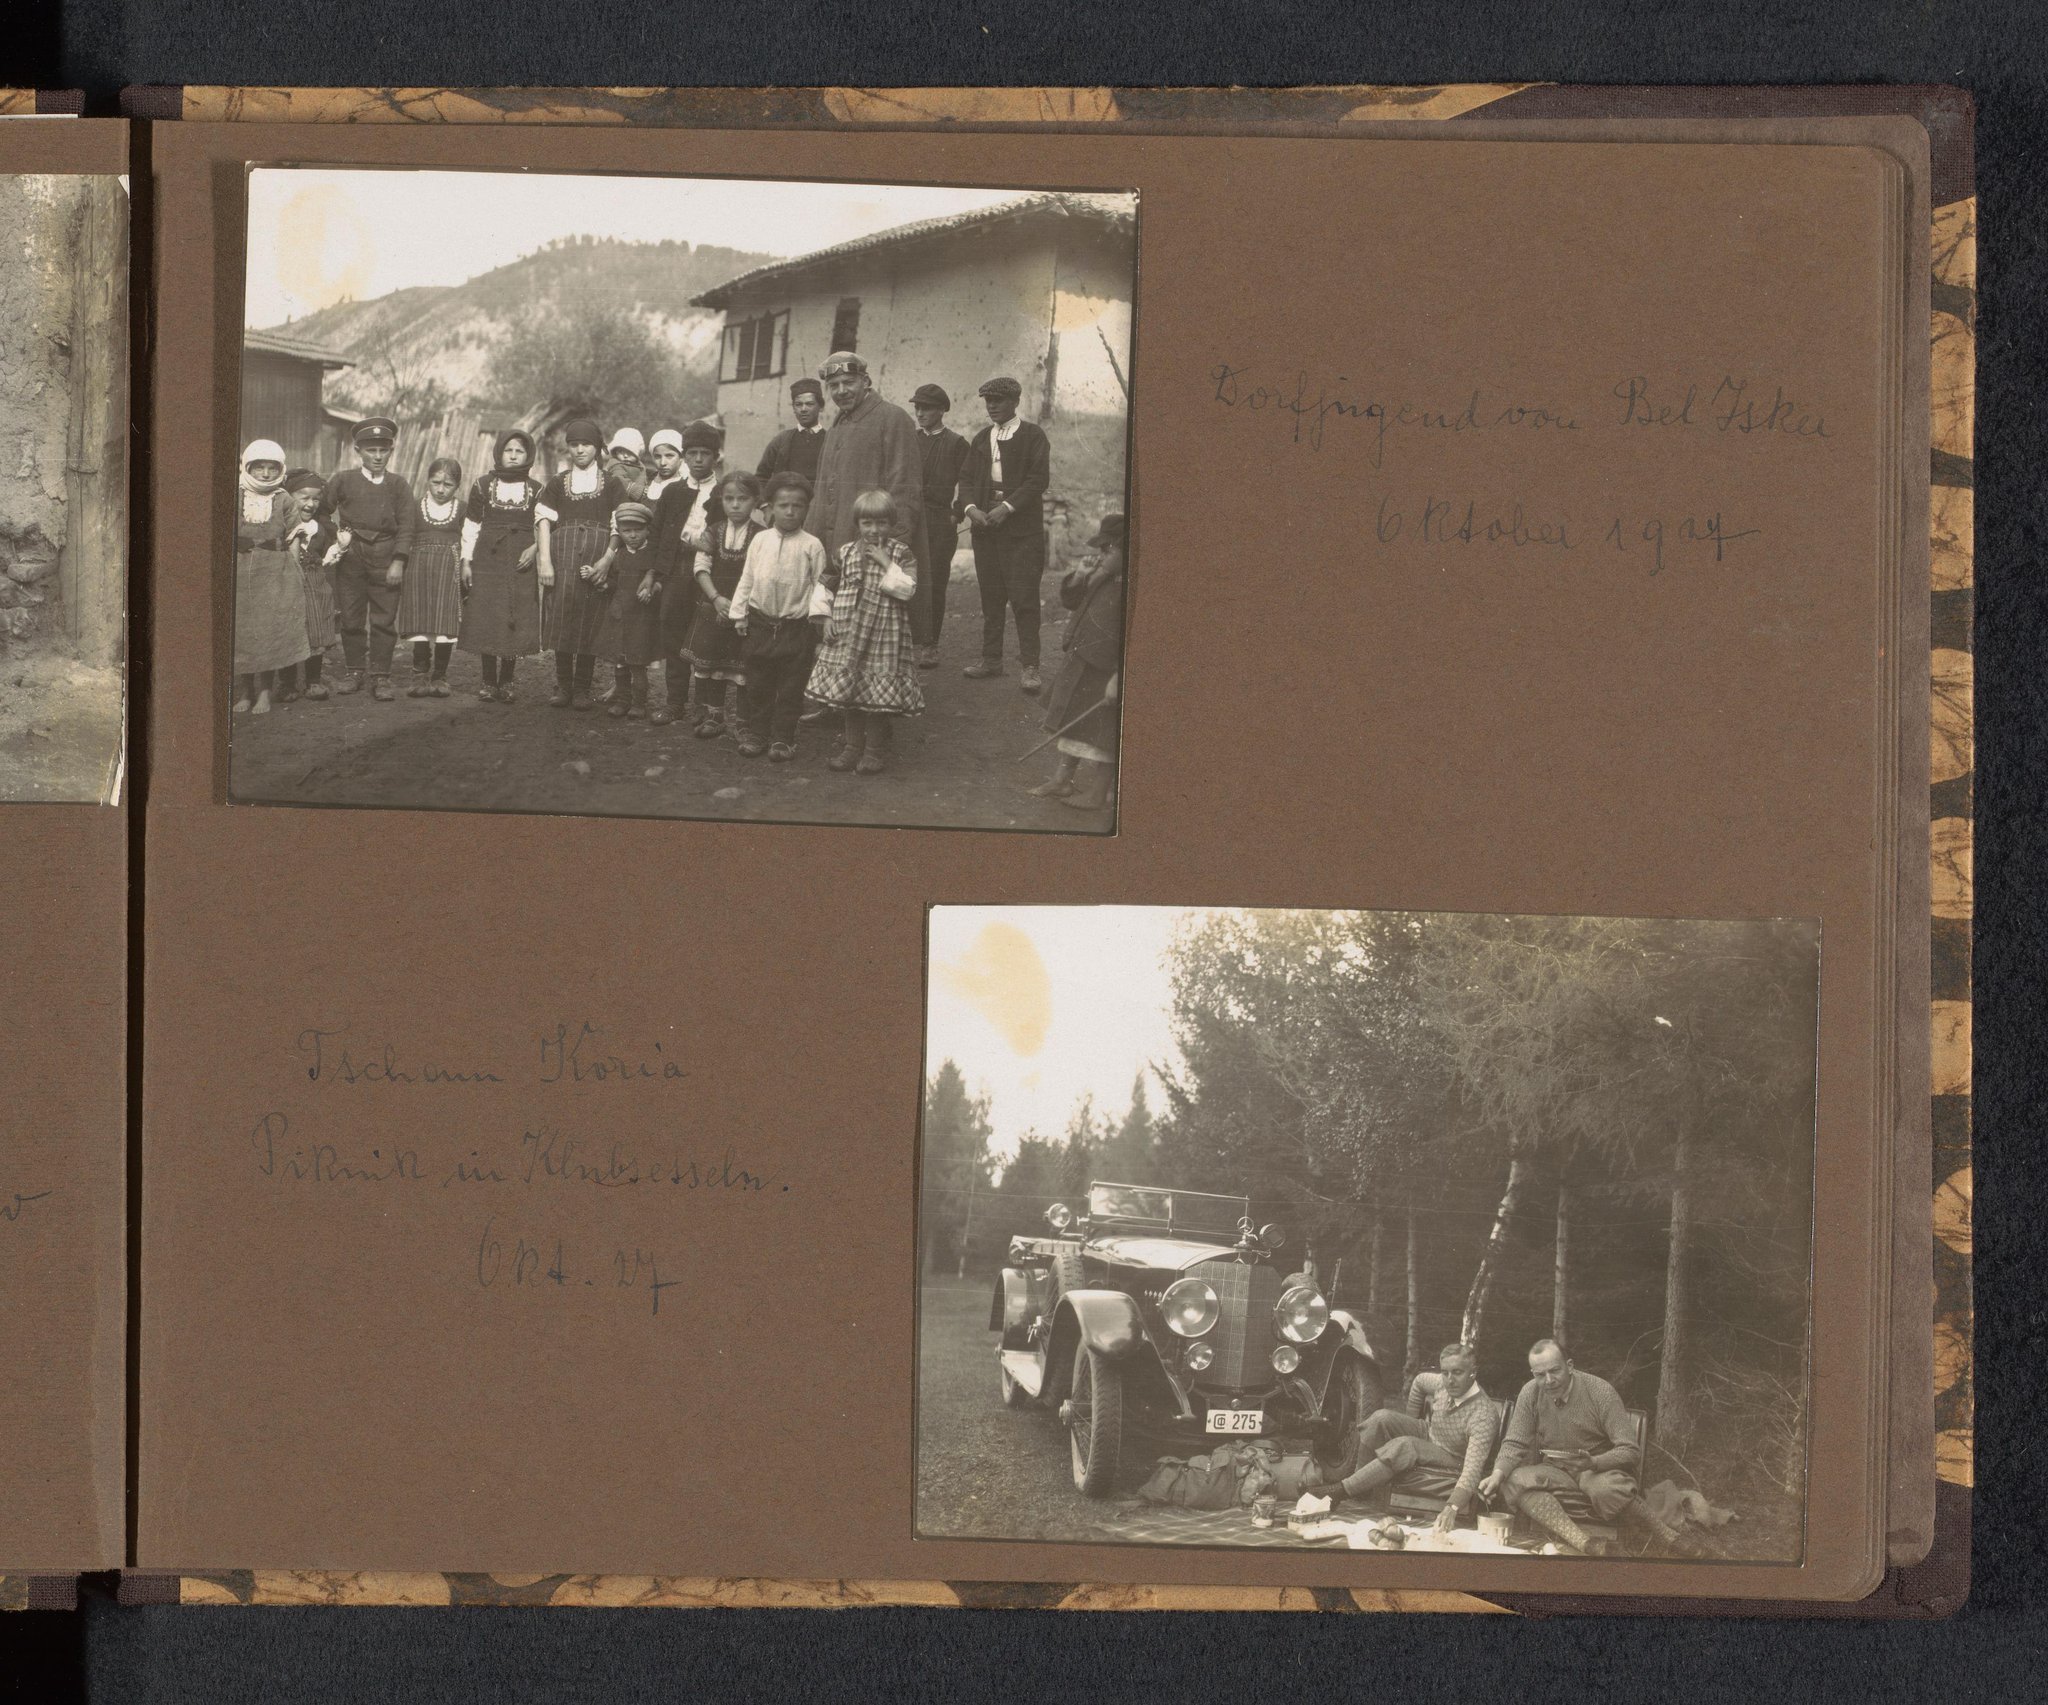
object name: album leaf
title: Bulgaarse kinderen en volwassenen in een Bulgaars dorp tijdens een rondreis van Else Wachenheimer-Moos en haar echtgenoot Eugen Wachenheimer, oktober 1927, Bulgarije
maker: else wachenheimer-moos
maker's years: 1895-1944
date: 1910-1927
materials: paper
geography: bulgaria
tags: eugen wachenheimer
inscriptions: inscription: ‘Tschonn Koria (onleesbaar)(onleesbaar)(onleesbaar) Okt. 27 Dorfjugend von Bel Isker Oktober 1927’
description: Albumblad bevat twee foto's van Eugen Wachenheimer en onbekende personen. Afkomstig uit album half formaat, kartonomslag met koordbinding en lichte veelvormige vormen op voorzijde.